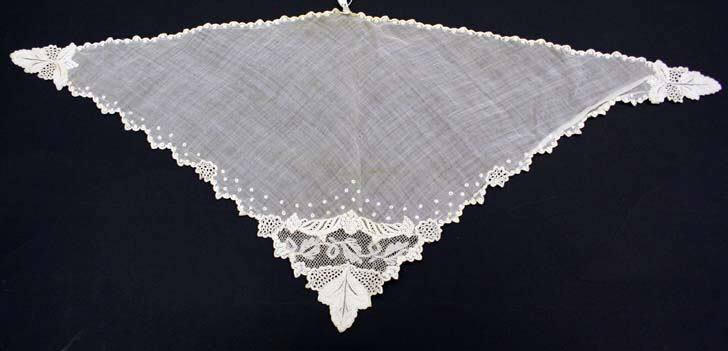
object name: kerchief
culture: american or european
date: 1801-1900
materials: cotton